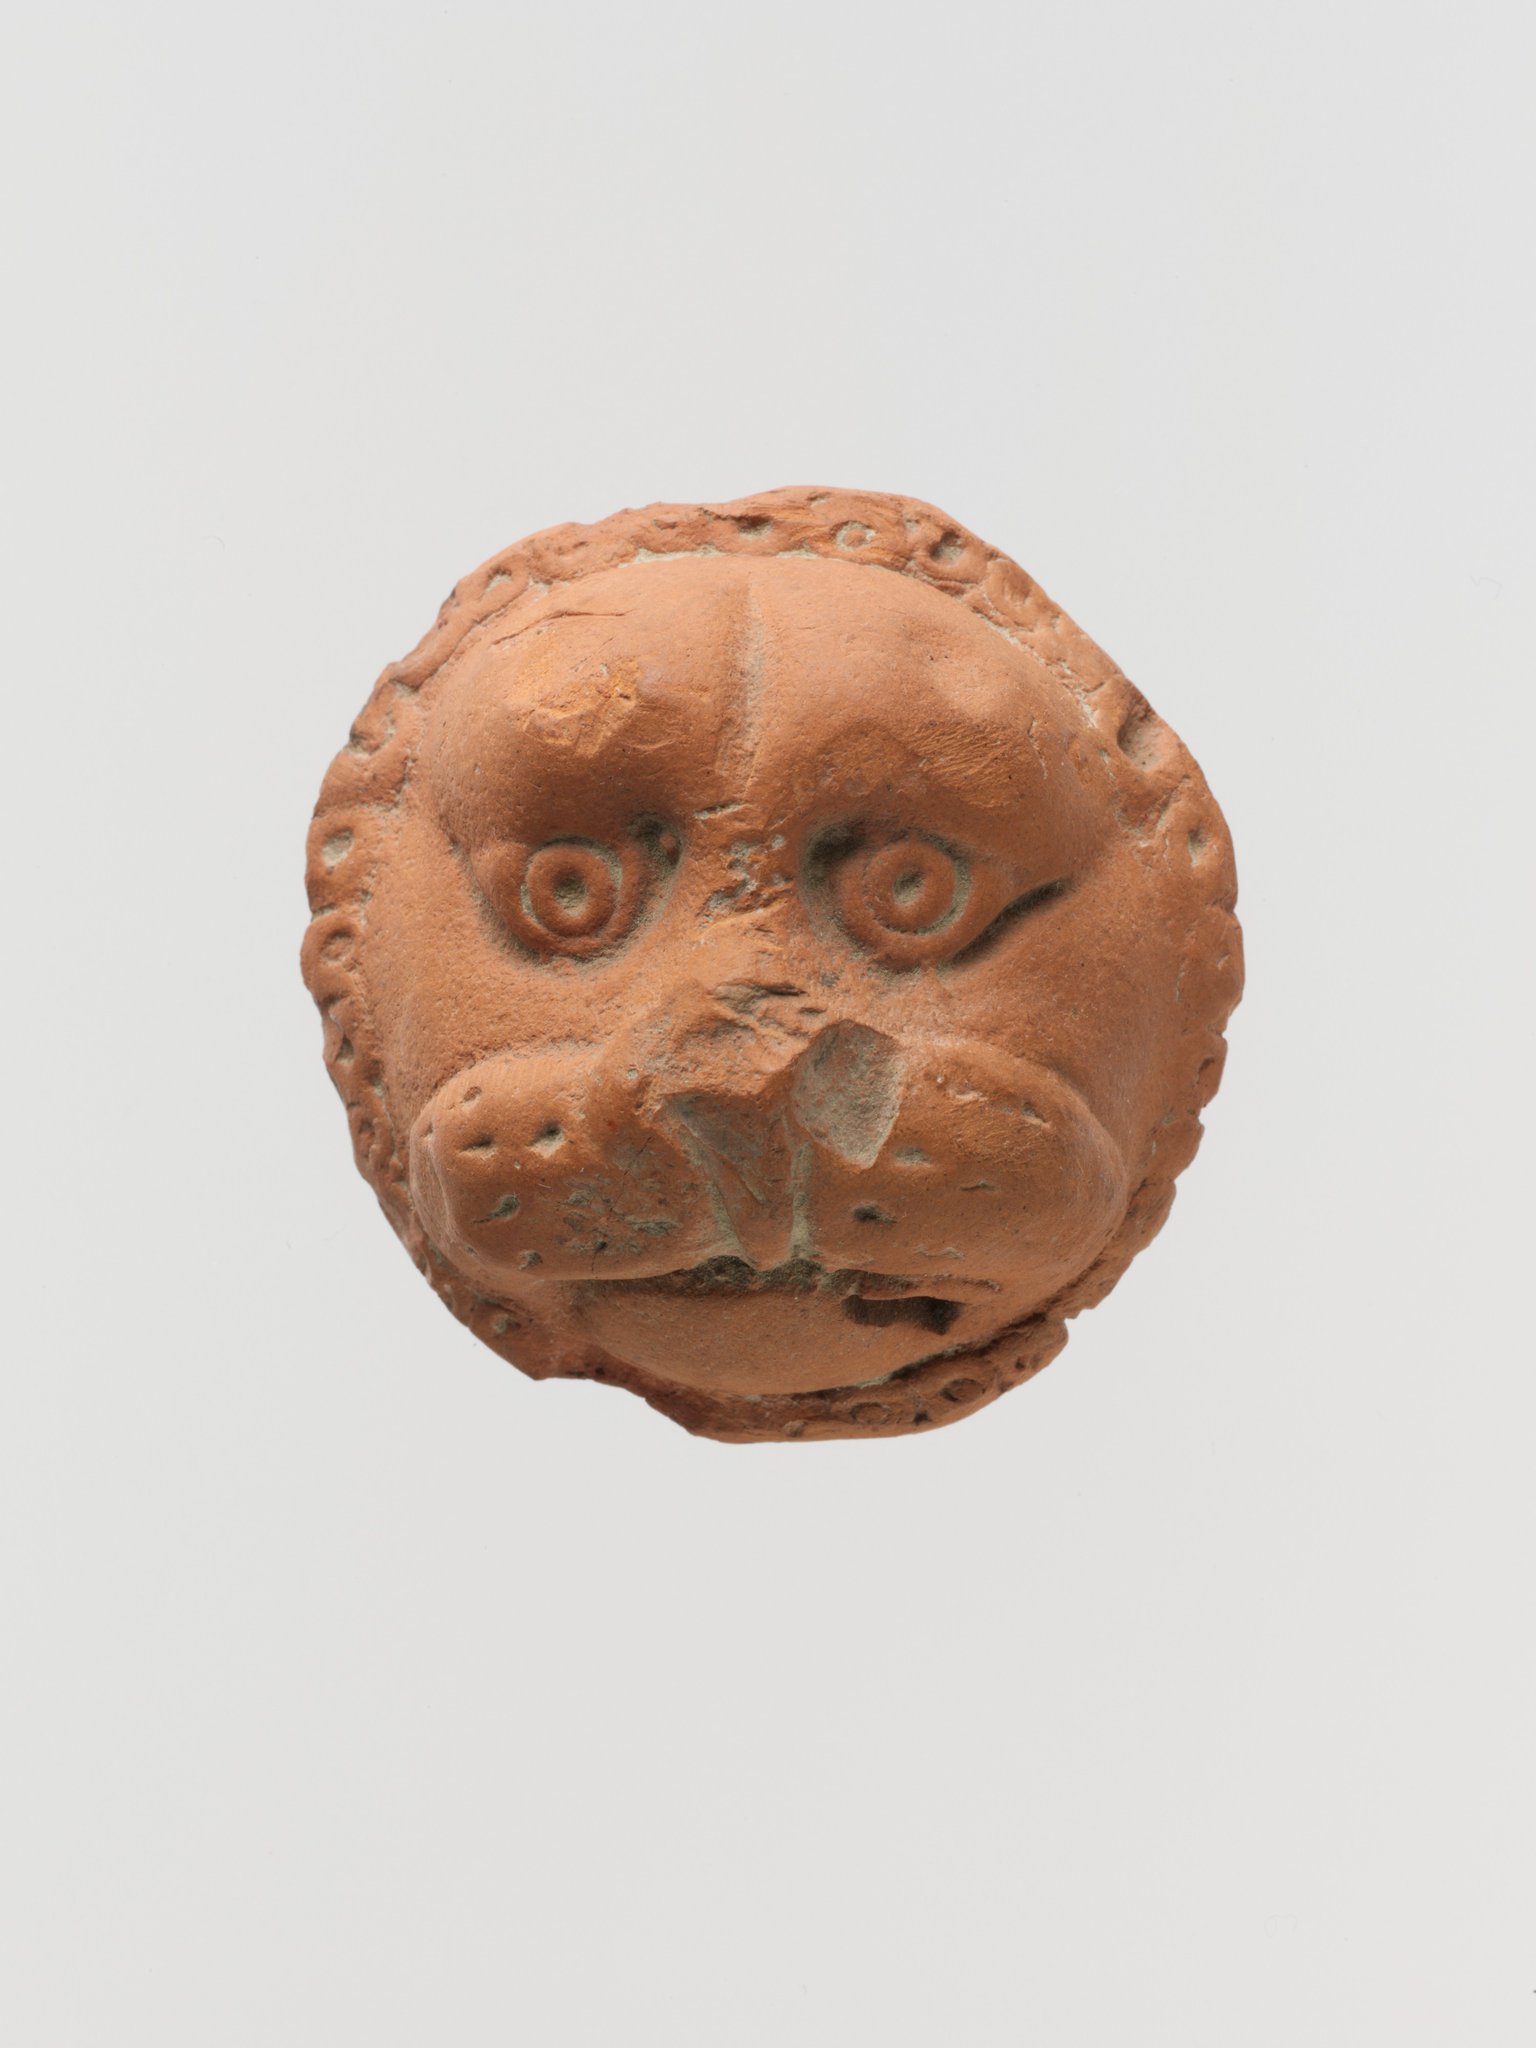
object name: mask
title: Lion Mask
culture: central asian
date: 1101-1133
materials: terracotta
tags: masks,lions